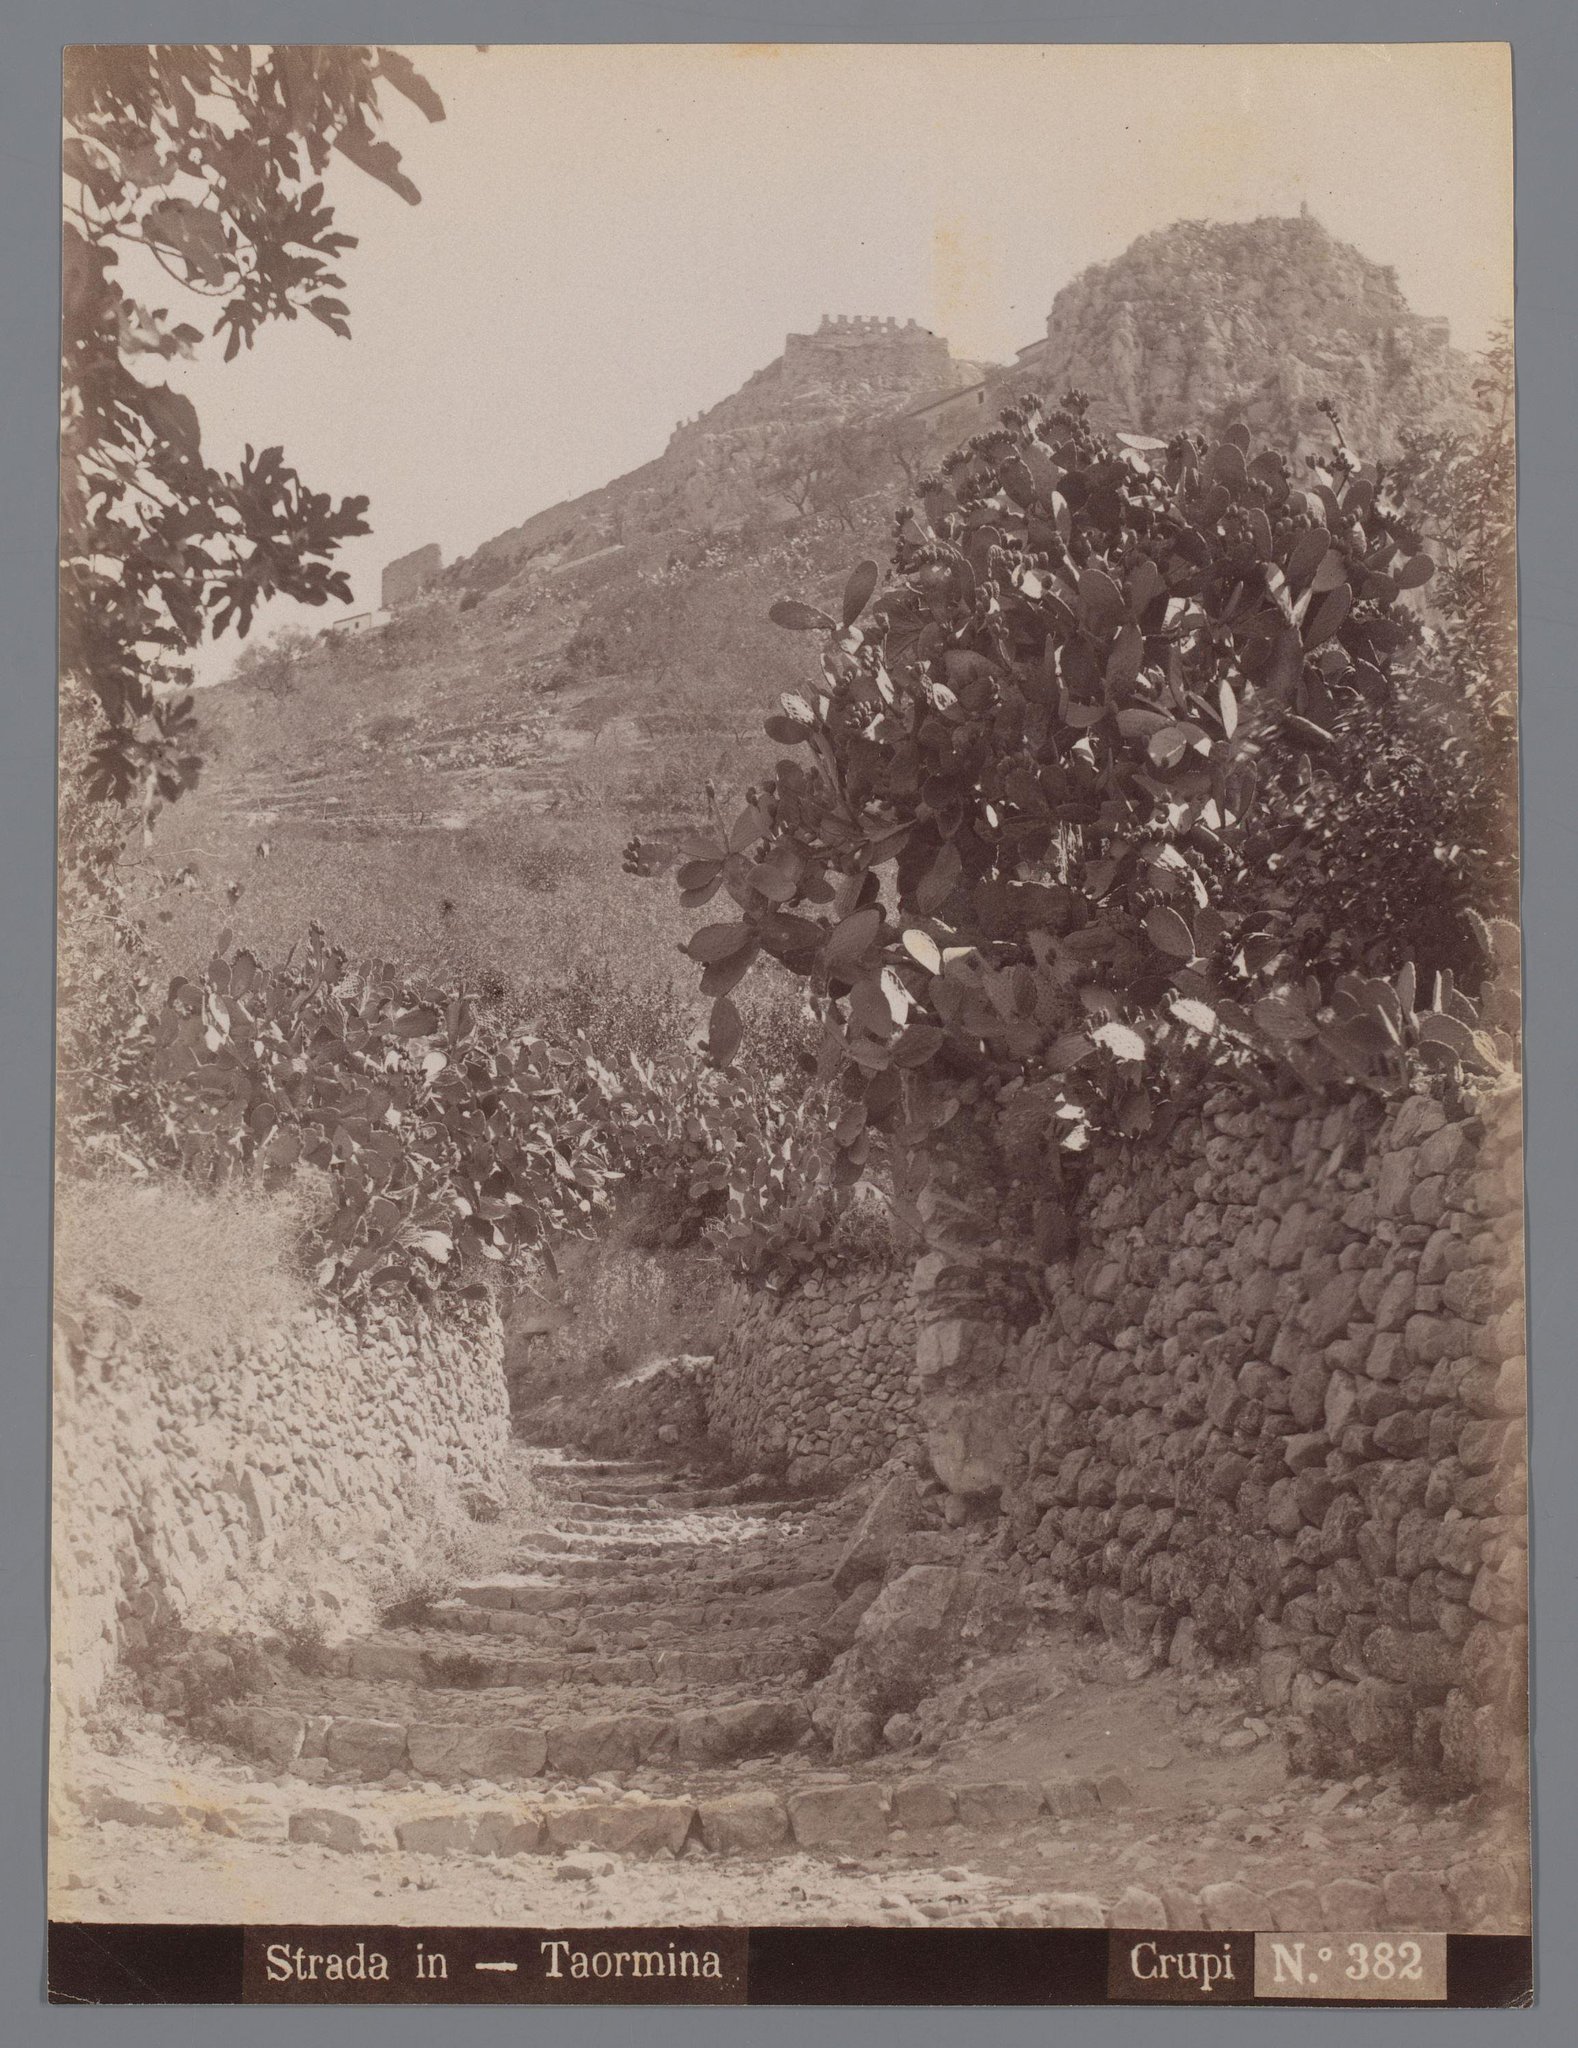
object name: photograph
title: Pad in Taormina, aan weerszijden begroeid met cactussen, Italië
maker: giovanni crupi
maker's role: fotograaf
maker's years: 1859-1925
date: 1851-1900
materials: cardboard, paper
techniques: albumen print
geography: taormina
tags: road, path, plants and herbs: cactus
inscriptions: number: ‘No. 382’